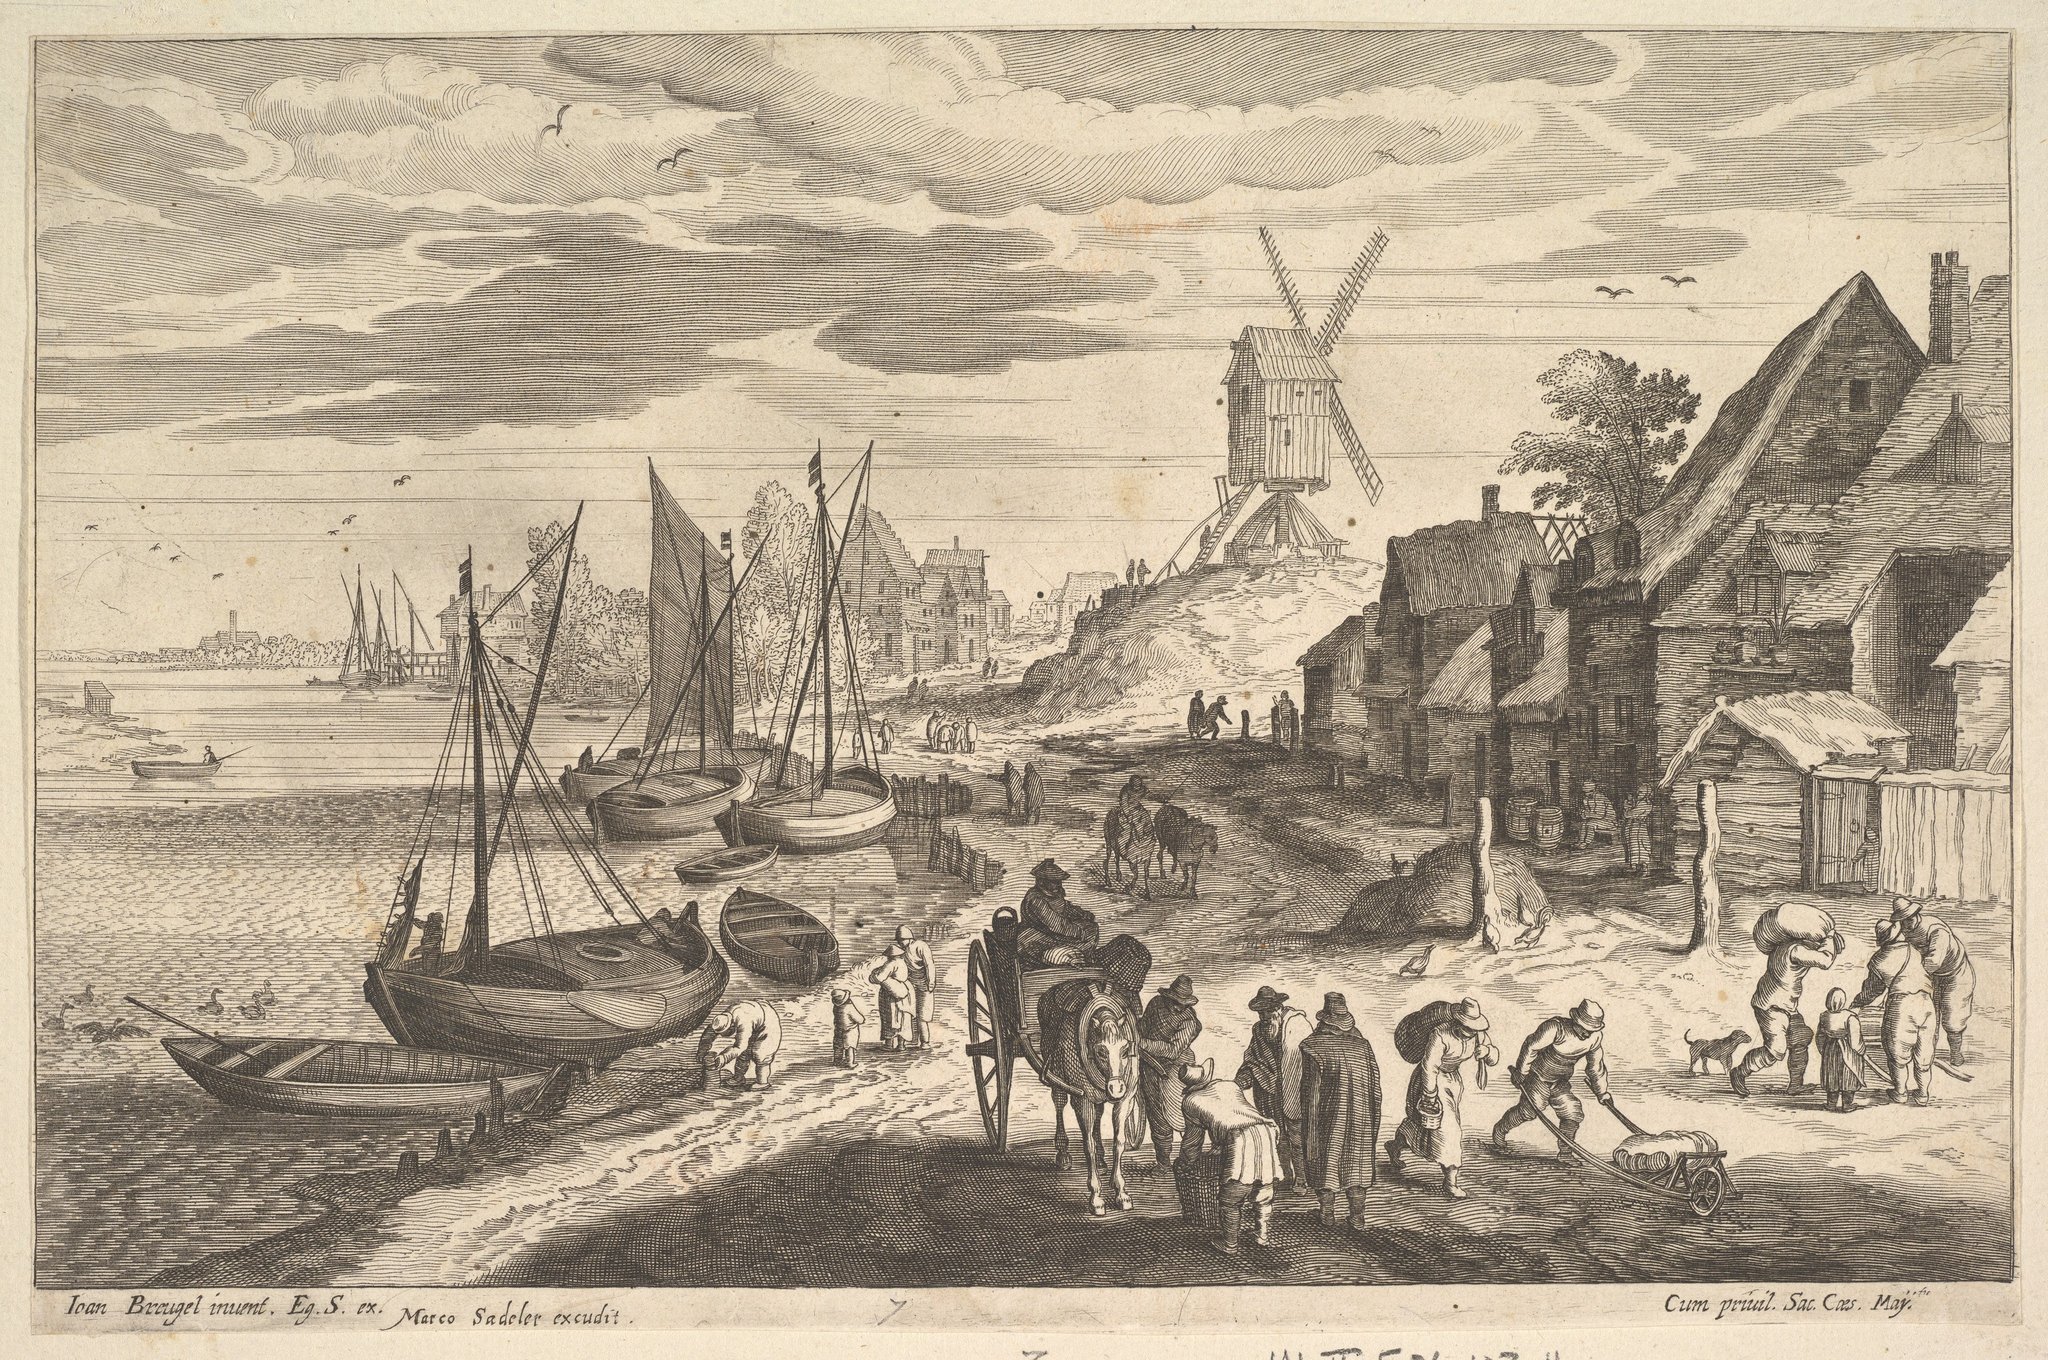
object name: print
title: Coast Scene with a Windmill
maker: aegidius sadeler (ii)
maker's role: artist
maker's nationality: flemish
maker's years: 1568-1629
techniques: engraving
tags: houses,windmills,boats